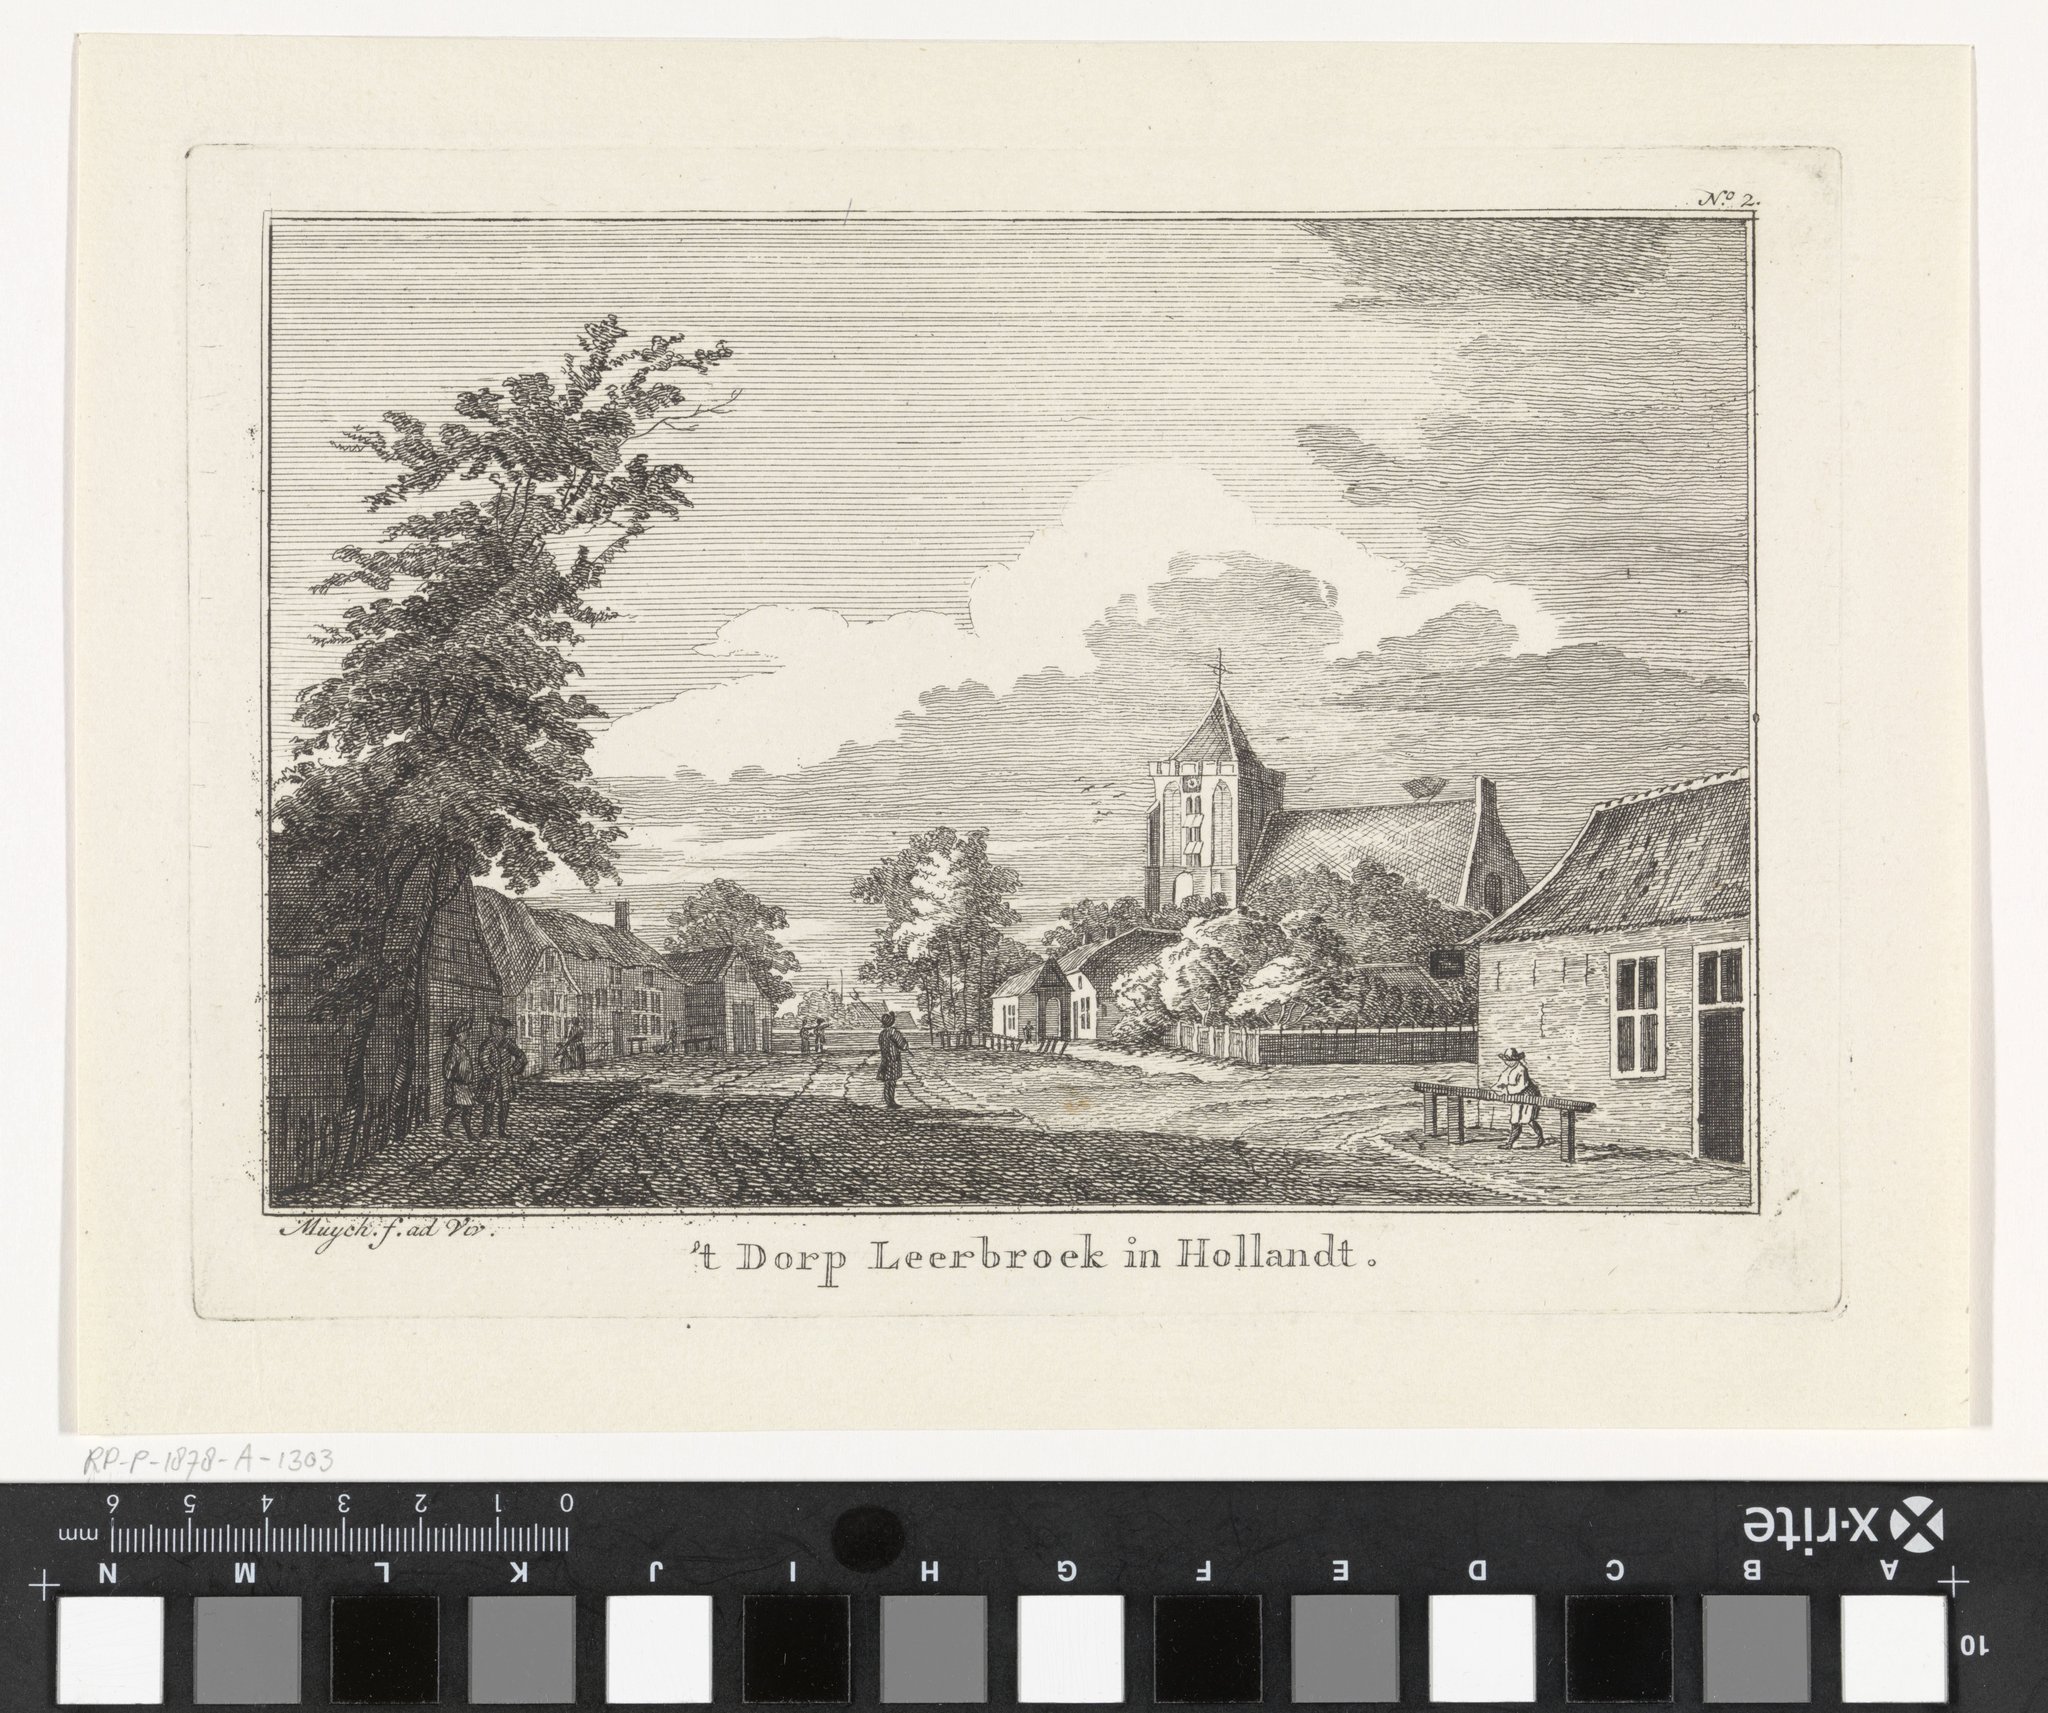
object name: print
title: 't Dorp Leerbroek in Hollandt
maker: muyck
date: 1740-1760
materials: paper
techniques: etching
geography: netherlands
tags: village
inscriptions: collector's mark: Lugt 2228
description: Gezicht op een straat in het dorp Leerbroek. Aan weerszijden van de straat woningen en rechts de kerk.